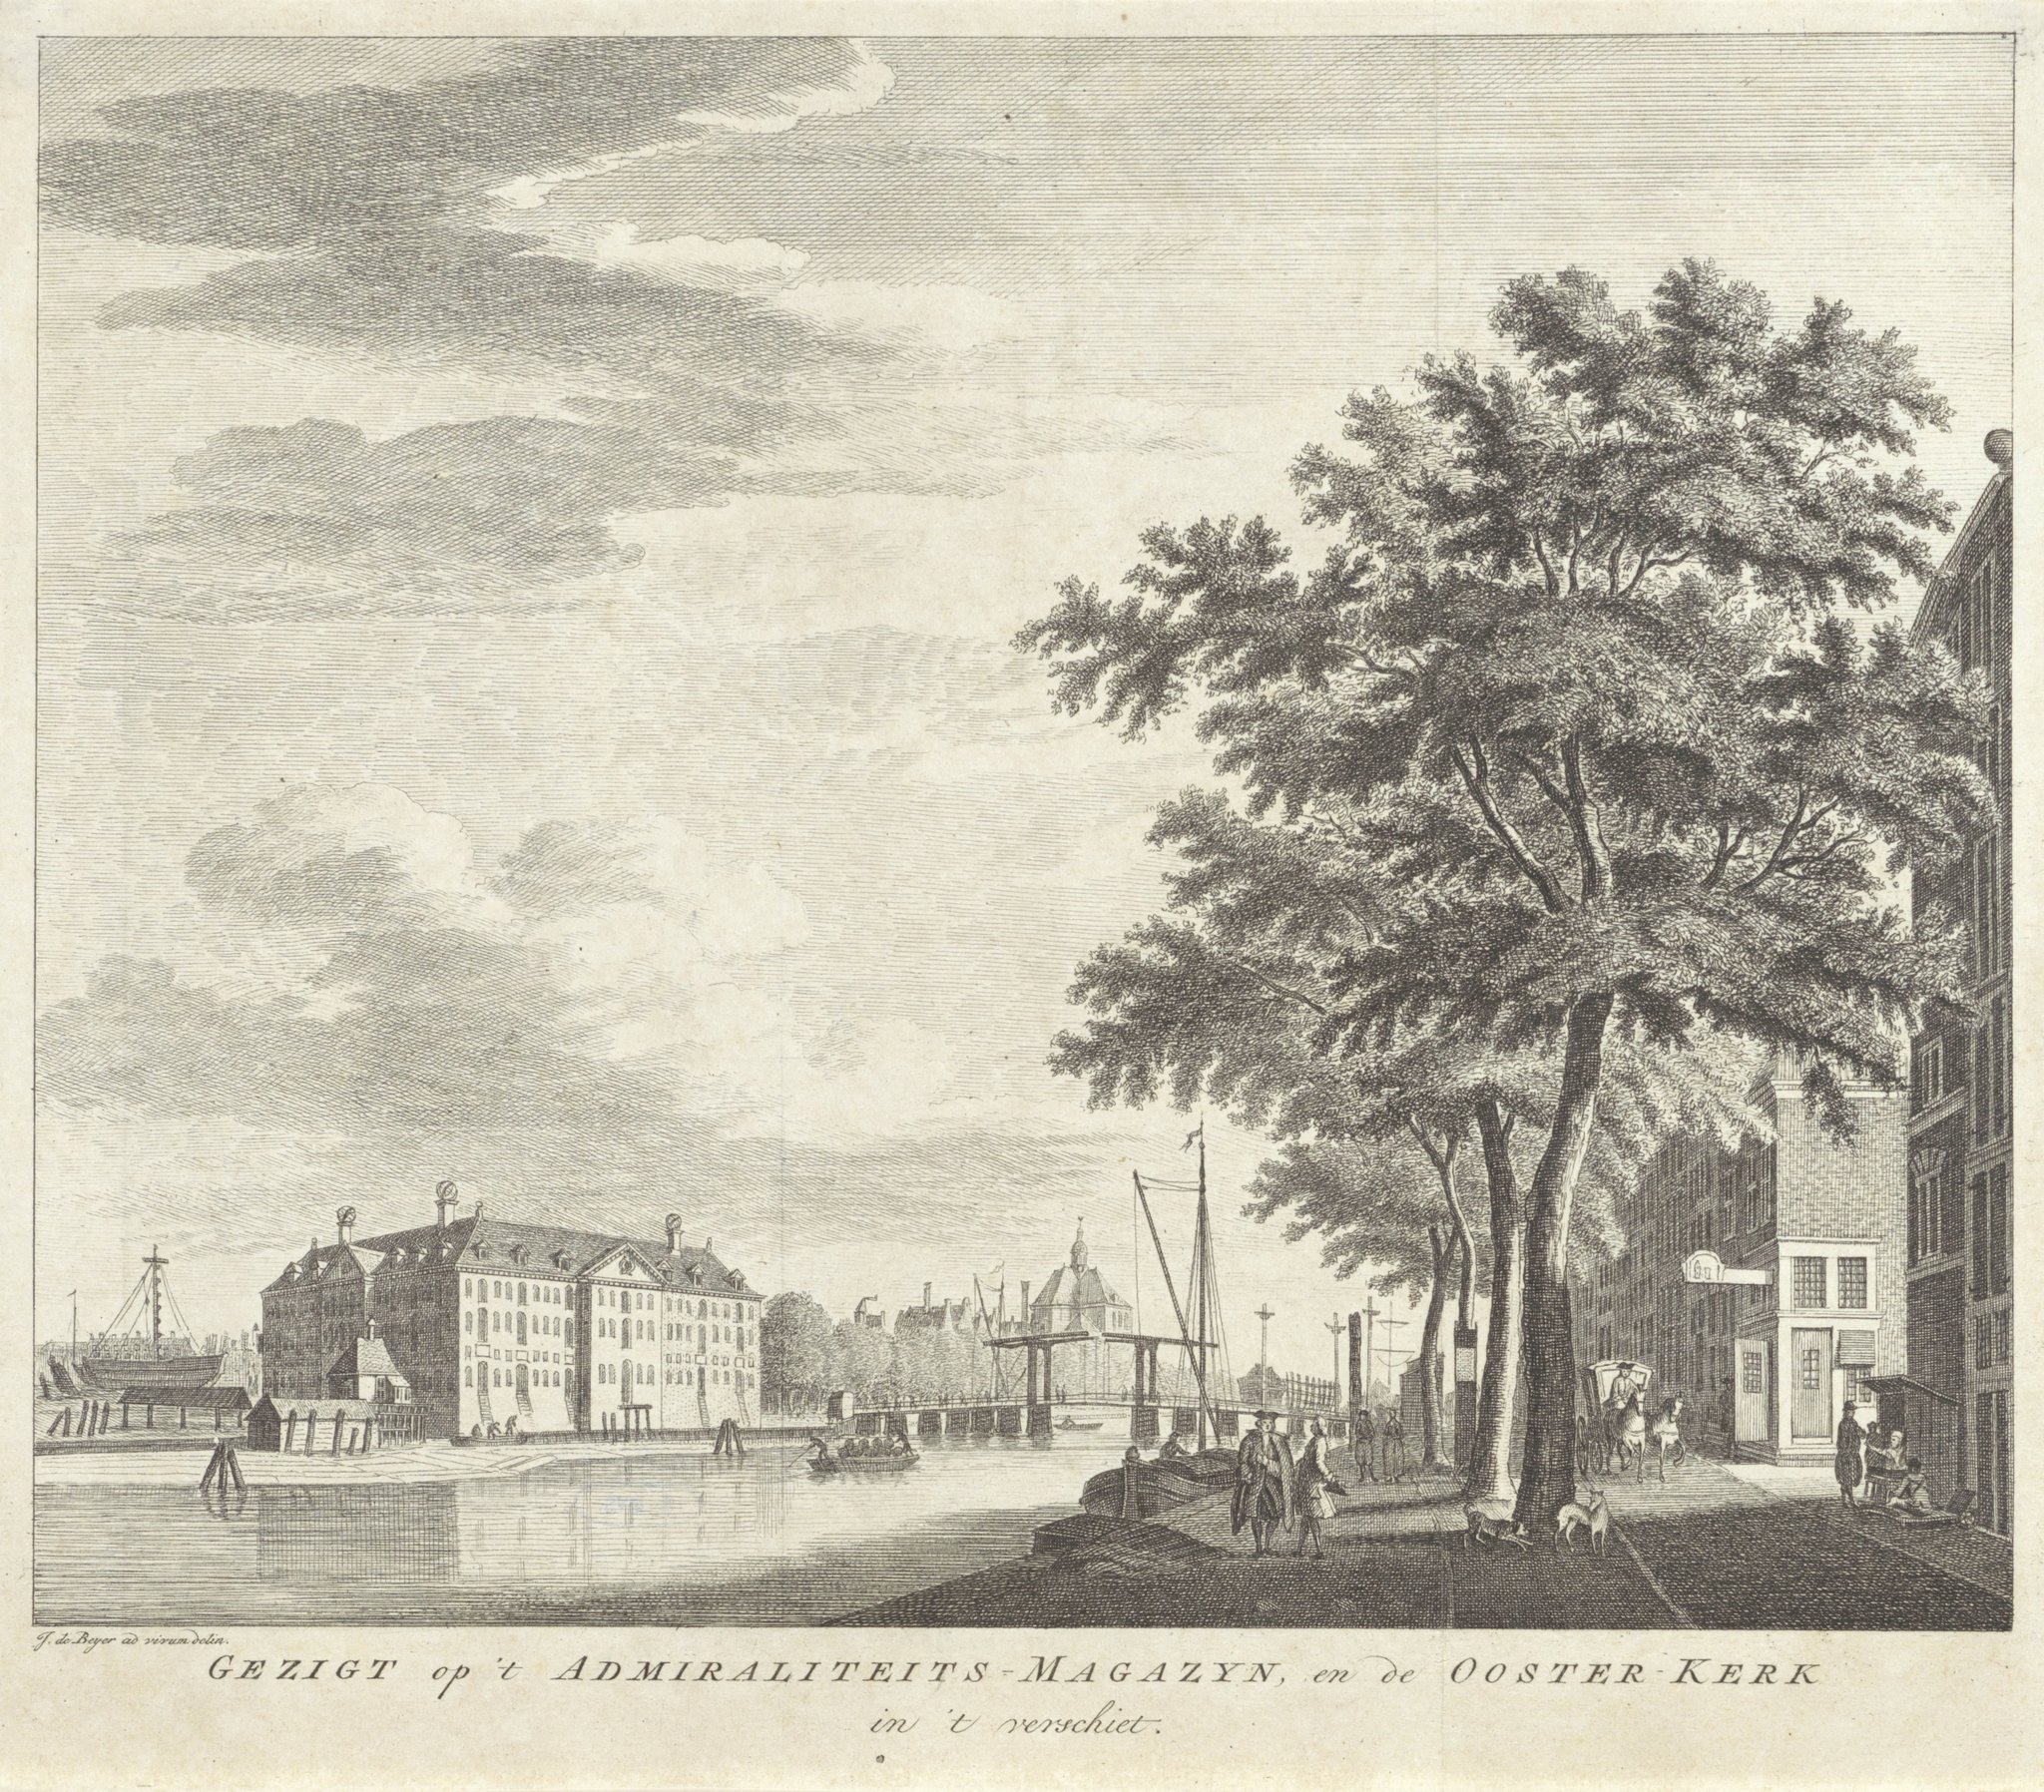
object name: print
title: Gezigt op 't Admiraliteits-Magazyn en de Ooster-Kerk in 't verschiet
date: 1718-1830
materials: paper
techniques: etching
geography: amsterdam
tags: city-view, and landscape with man-made constructions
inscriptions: collector's mark: Lugt 2228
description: Gezicht op de Nieuwe Vaart te Amsterdam met links het Admiraliteitsmagazijn en in de verte de Oosterkerk.